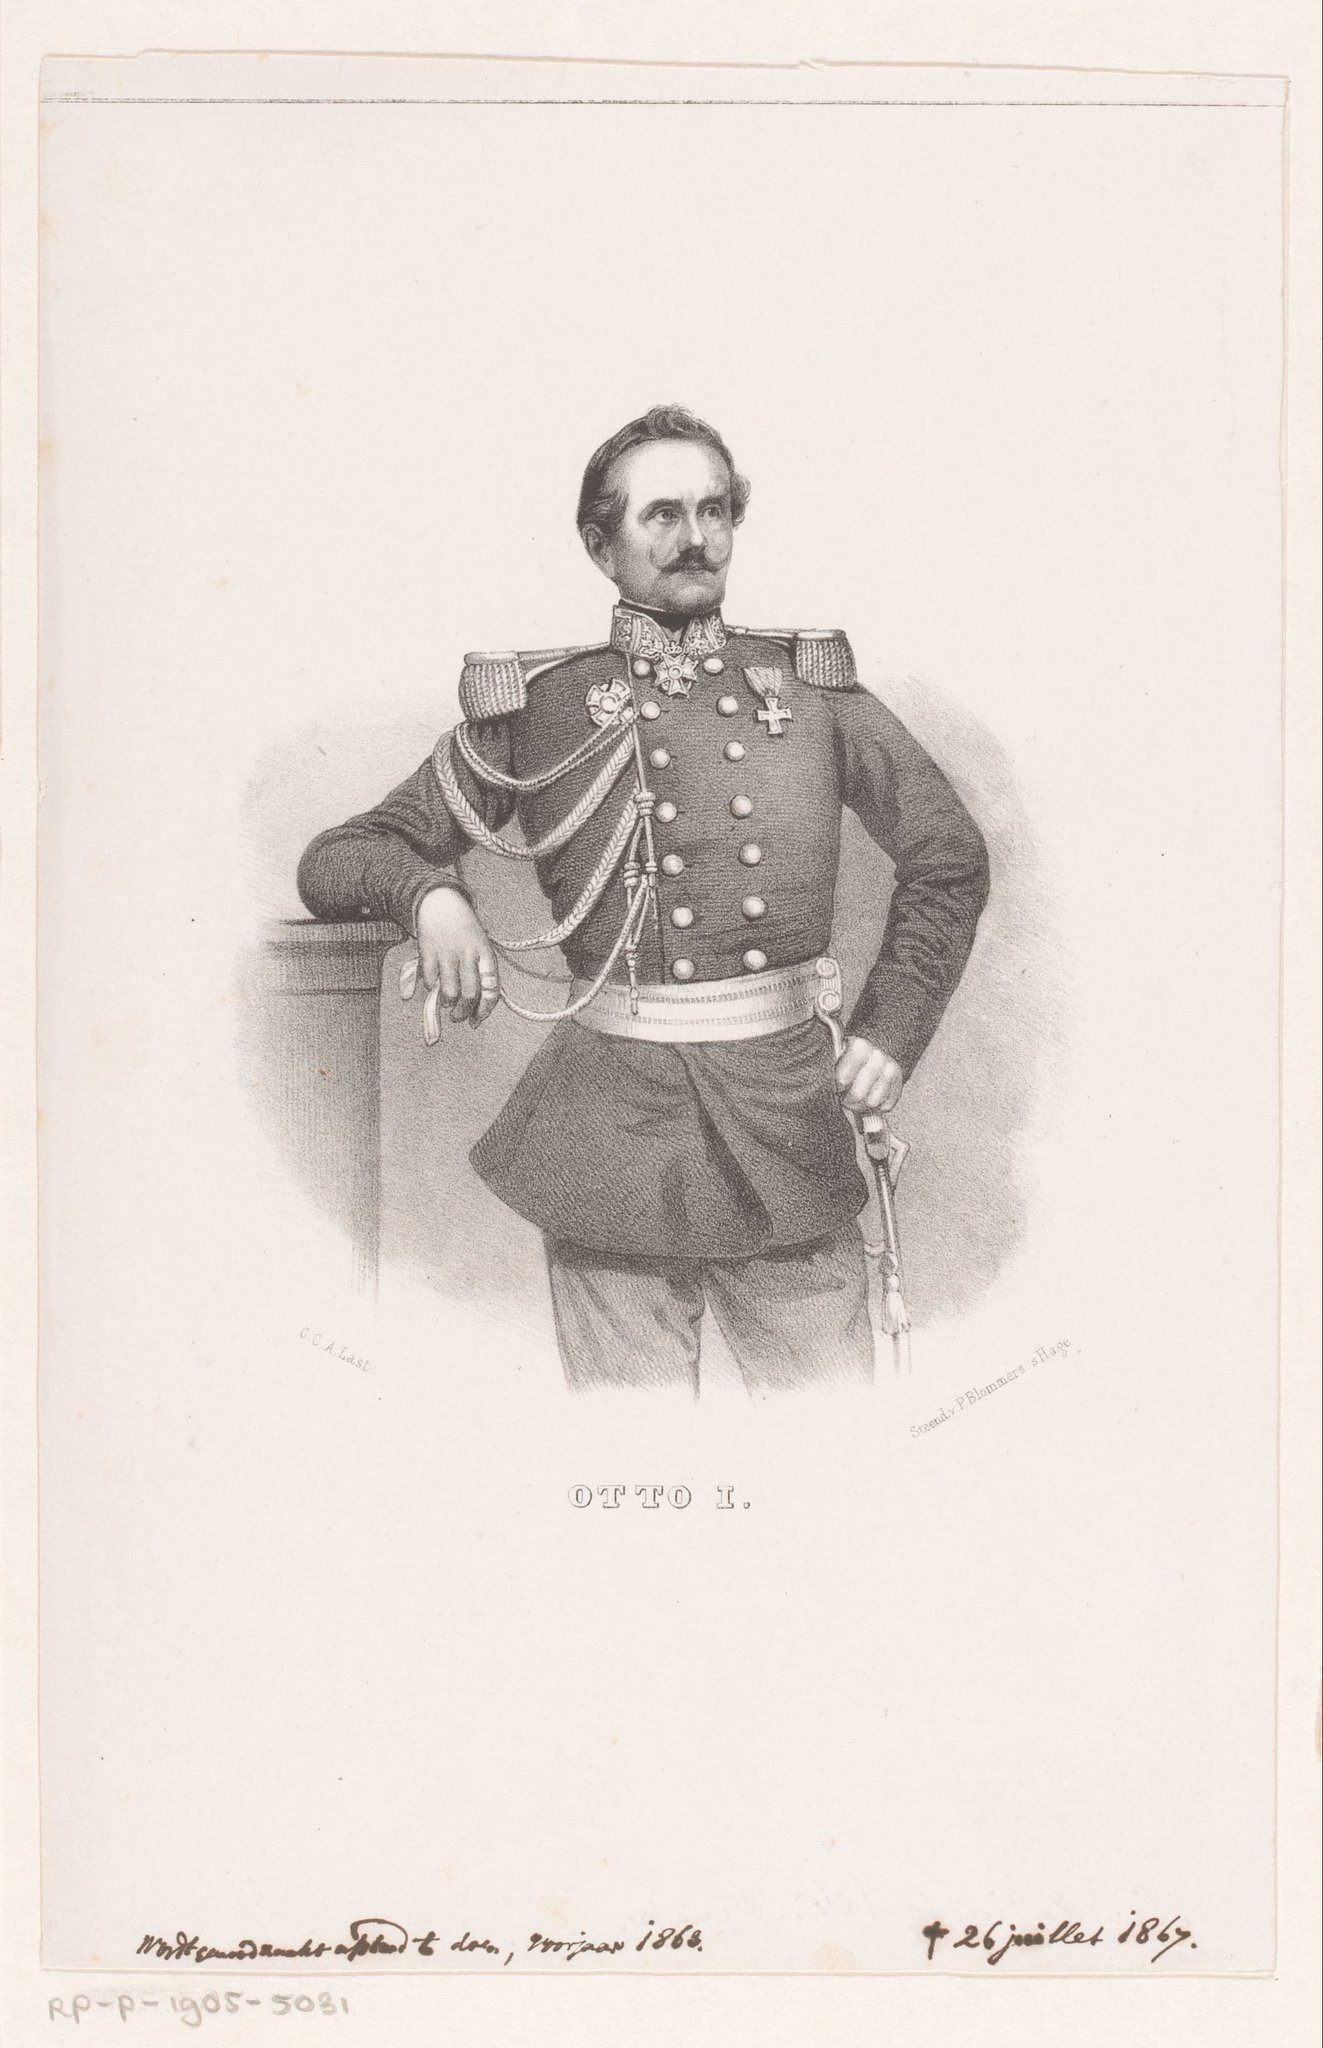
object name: print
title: Portret van Otto I, koning van Griekenland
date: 1842-1887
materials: paper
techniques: lithograph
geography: the hague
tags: knighthood order, historical persons (+ half-length portrait)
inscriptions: collector's mark: Lugt 2228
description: De geportretteerde staat en leunt met zijn rechterarm op een verhoging. Hij draagt een militair uniform met onderscheidingen en epauletten.